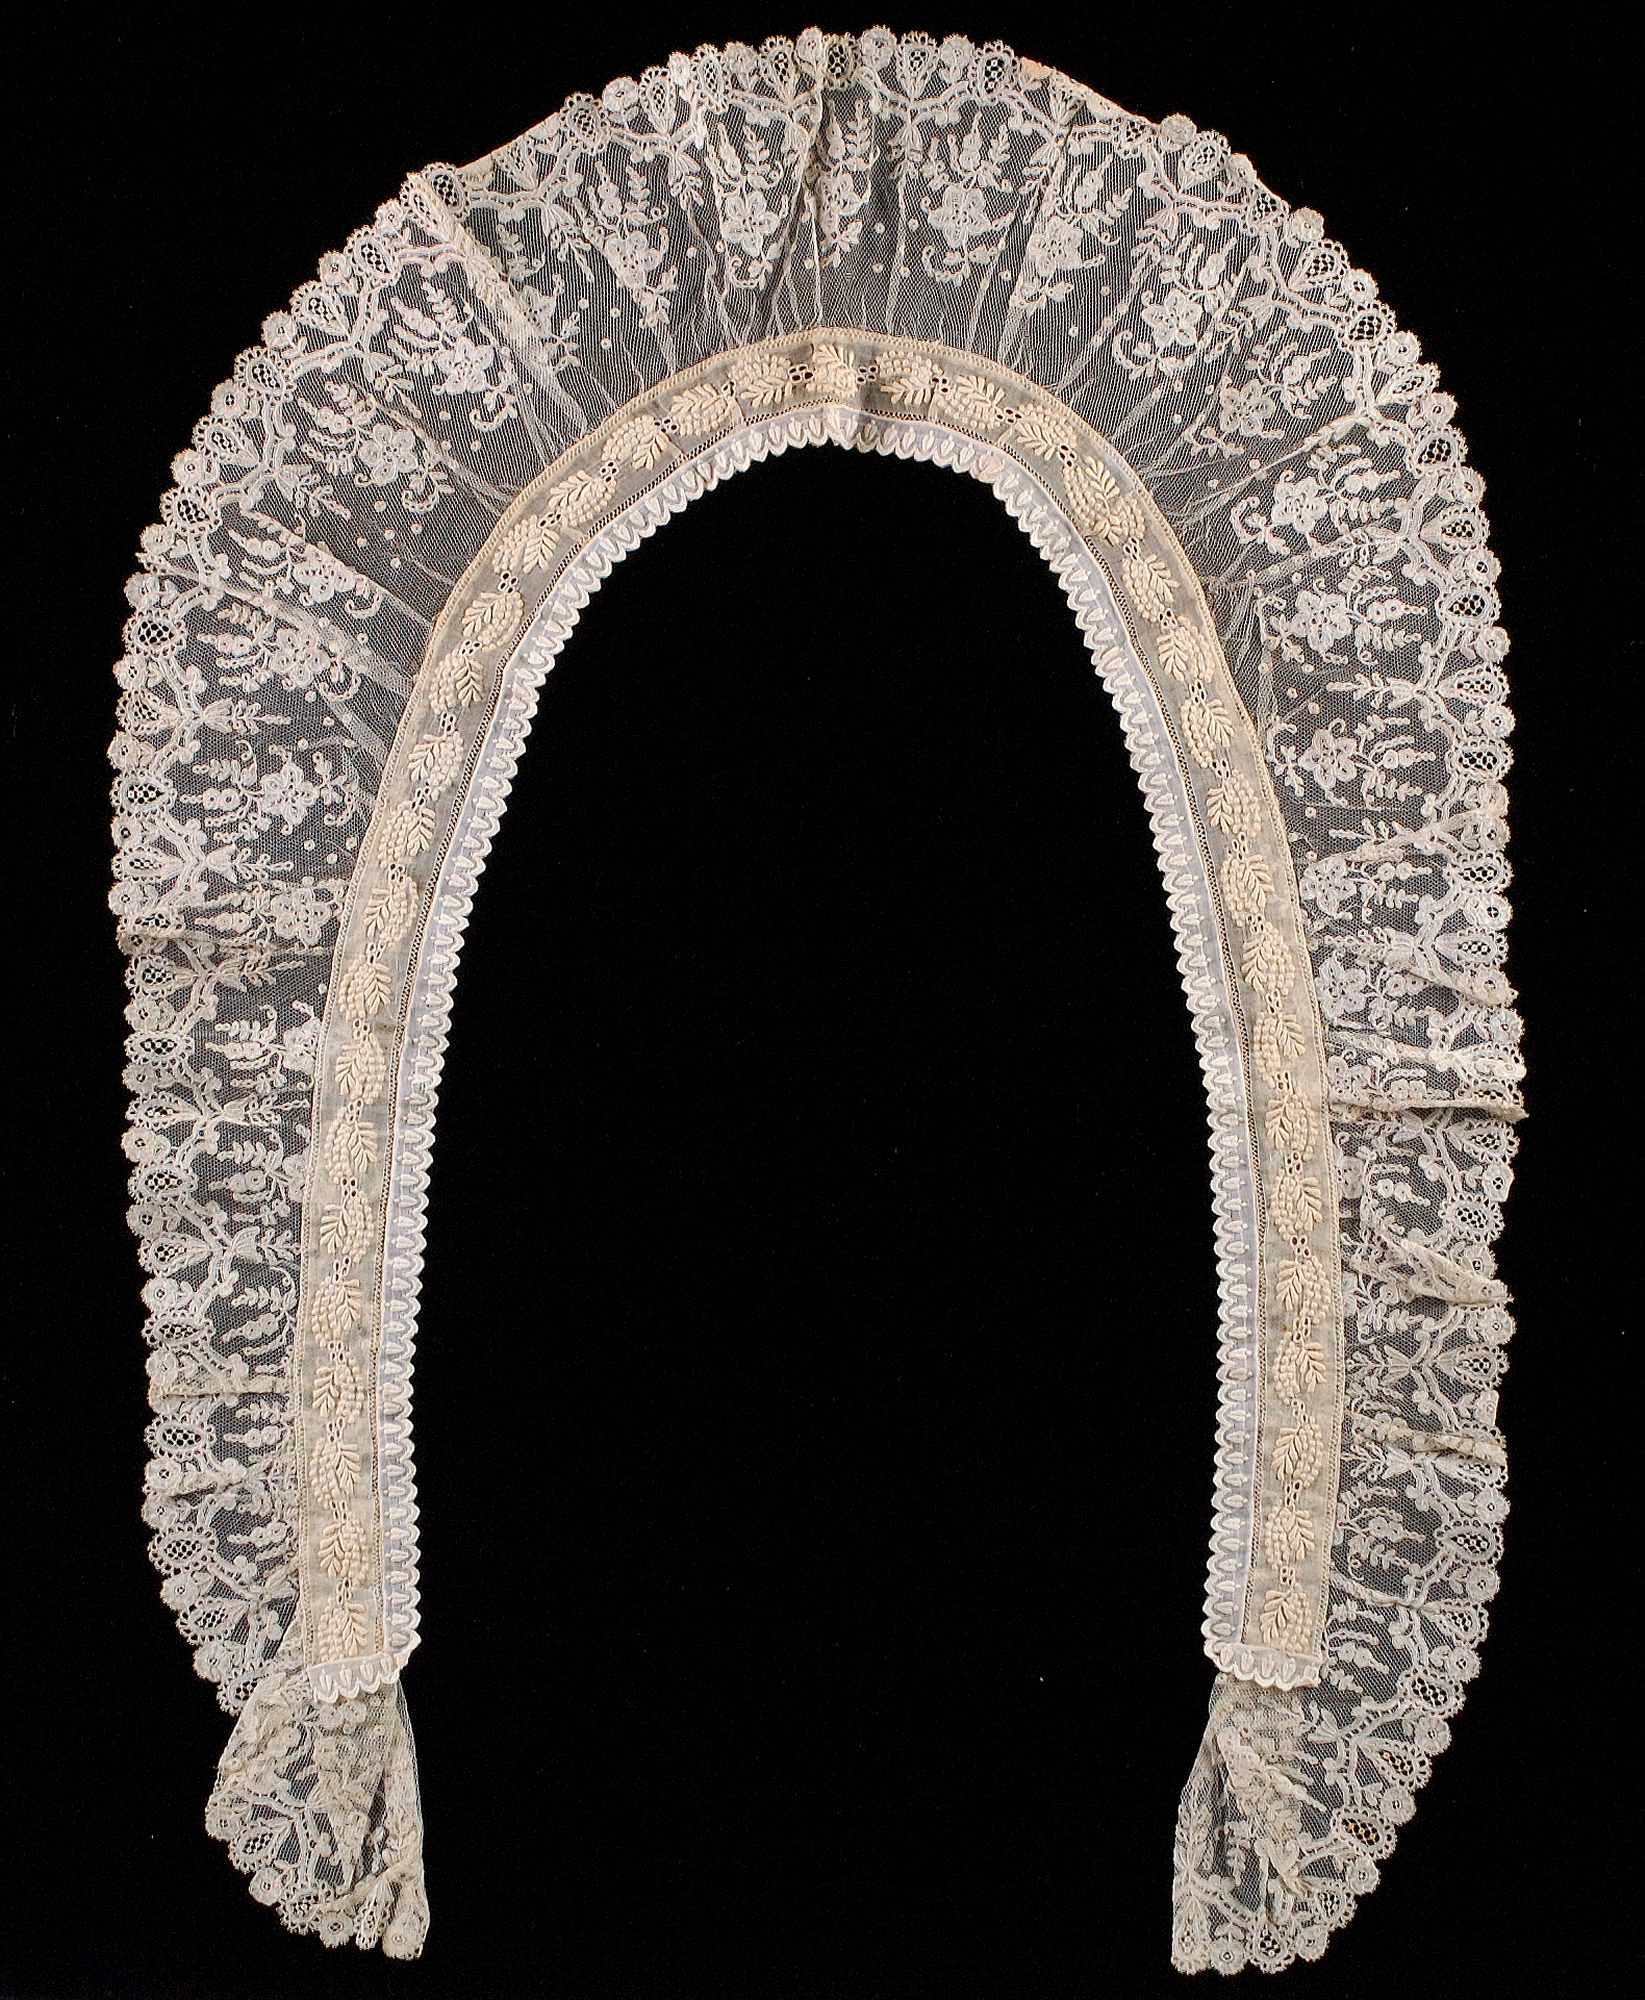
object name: fichu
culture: american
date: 1890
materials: cotton, linen, silk